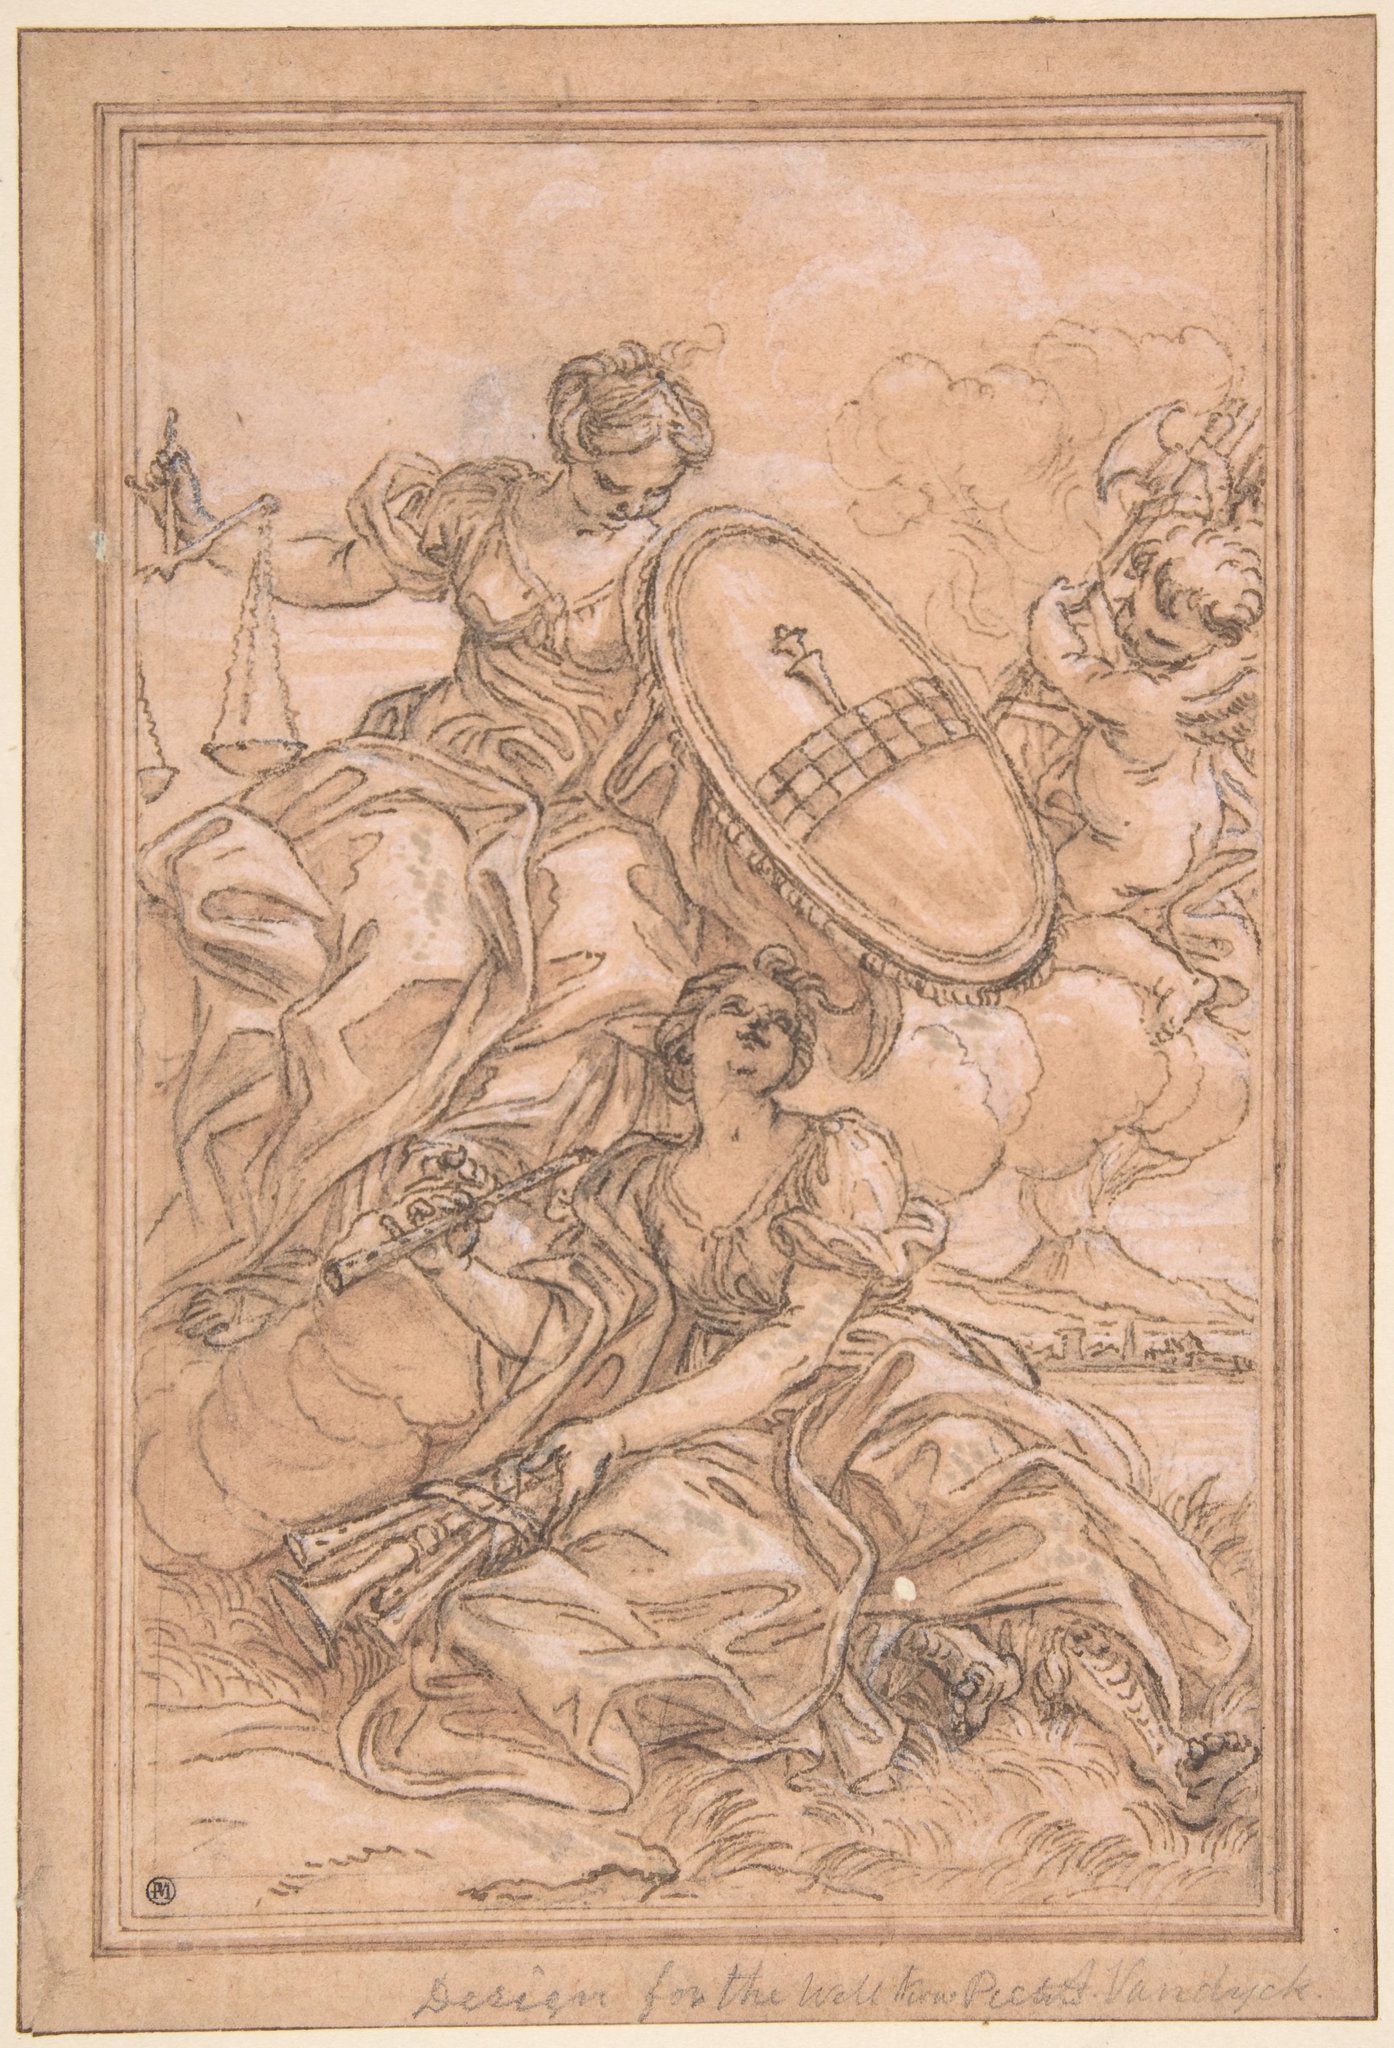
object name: drawing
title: Allegorical Composition: Music and Justice with the Spinola Arms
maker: giovanni battista gaulli (il baciccio)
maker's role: artist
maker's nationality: italian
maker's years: 1639-1709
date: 1639-1709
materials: chalk, ink, paper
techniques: brush, highlighting, pen, wash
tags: musical instruments,shields,women